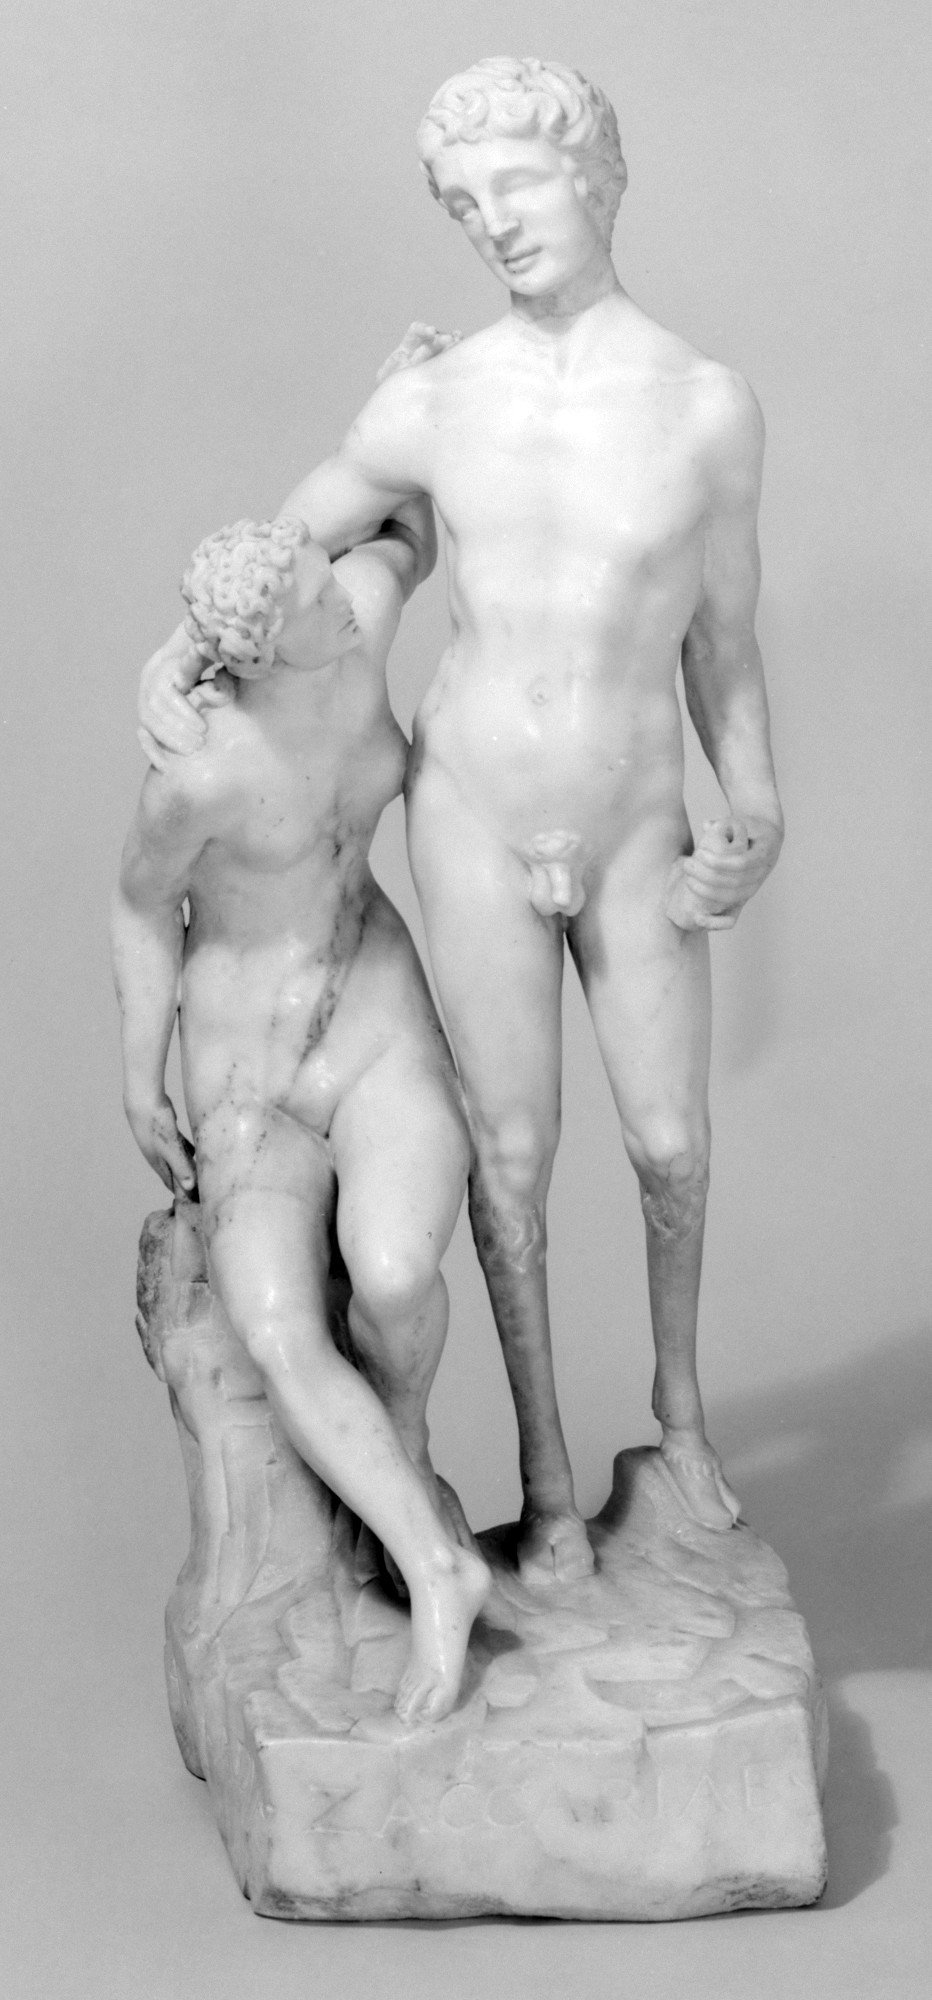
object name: statuette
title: Nymph and satyr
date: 1506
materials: marble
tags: nymphs,satyrs